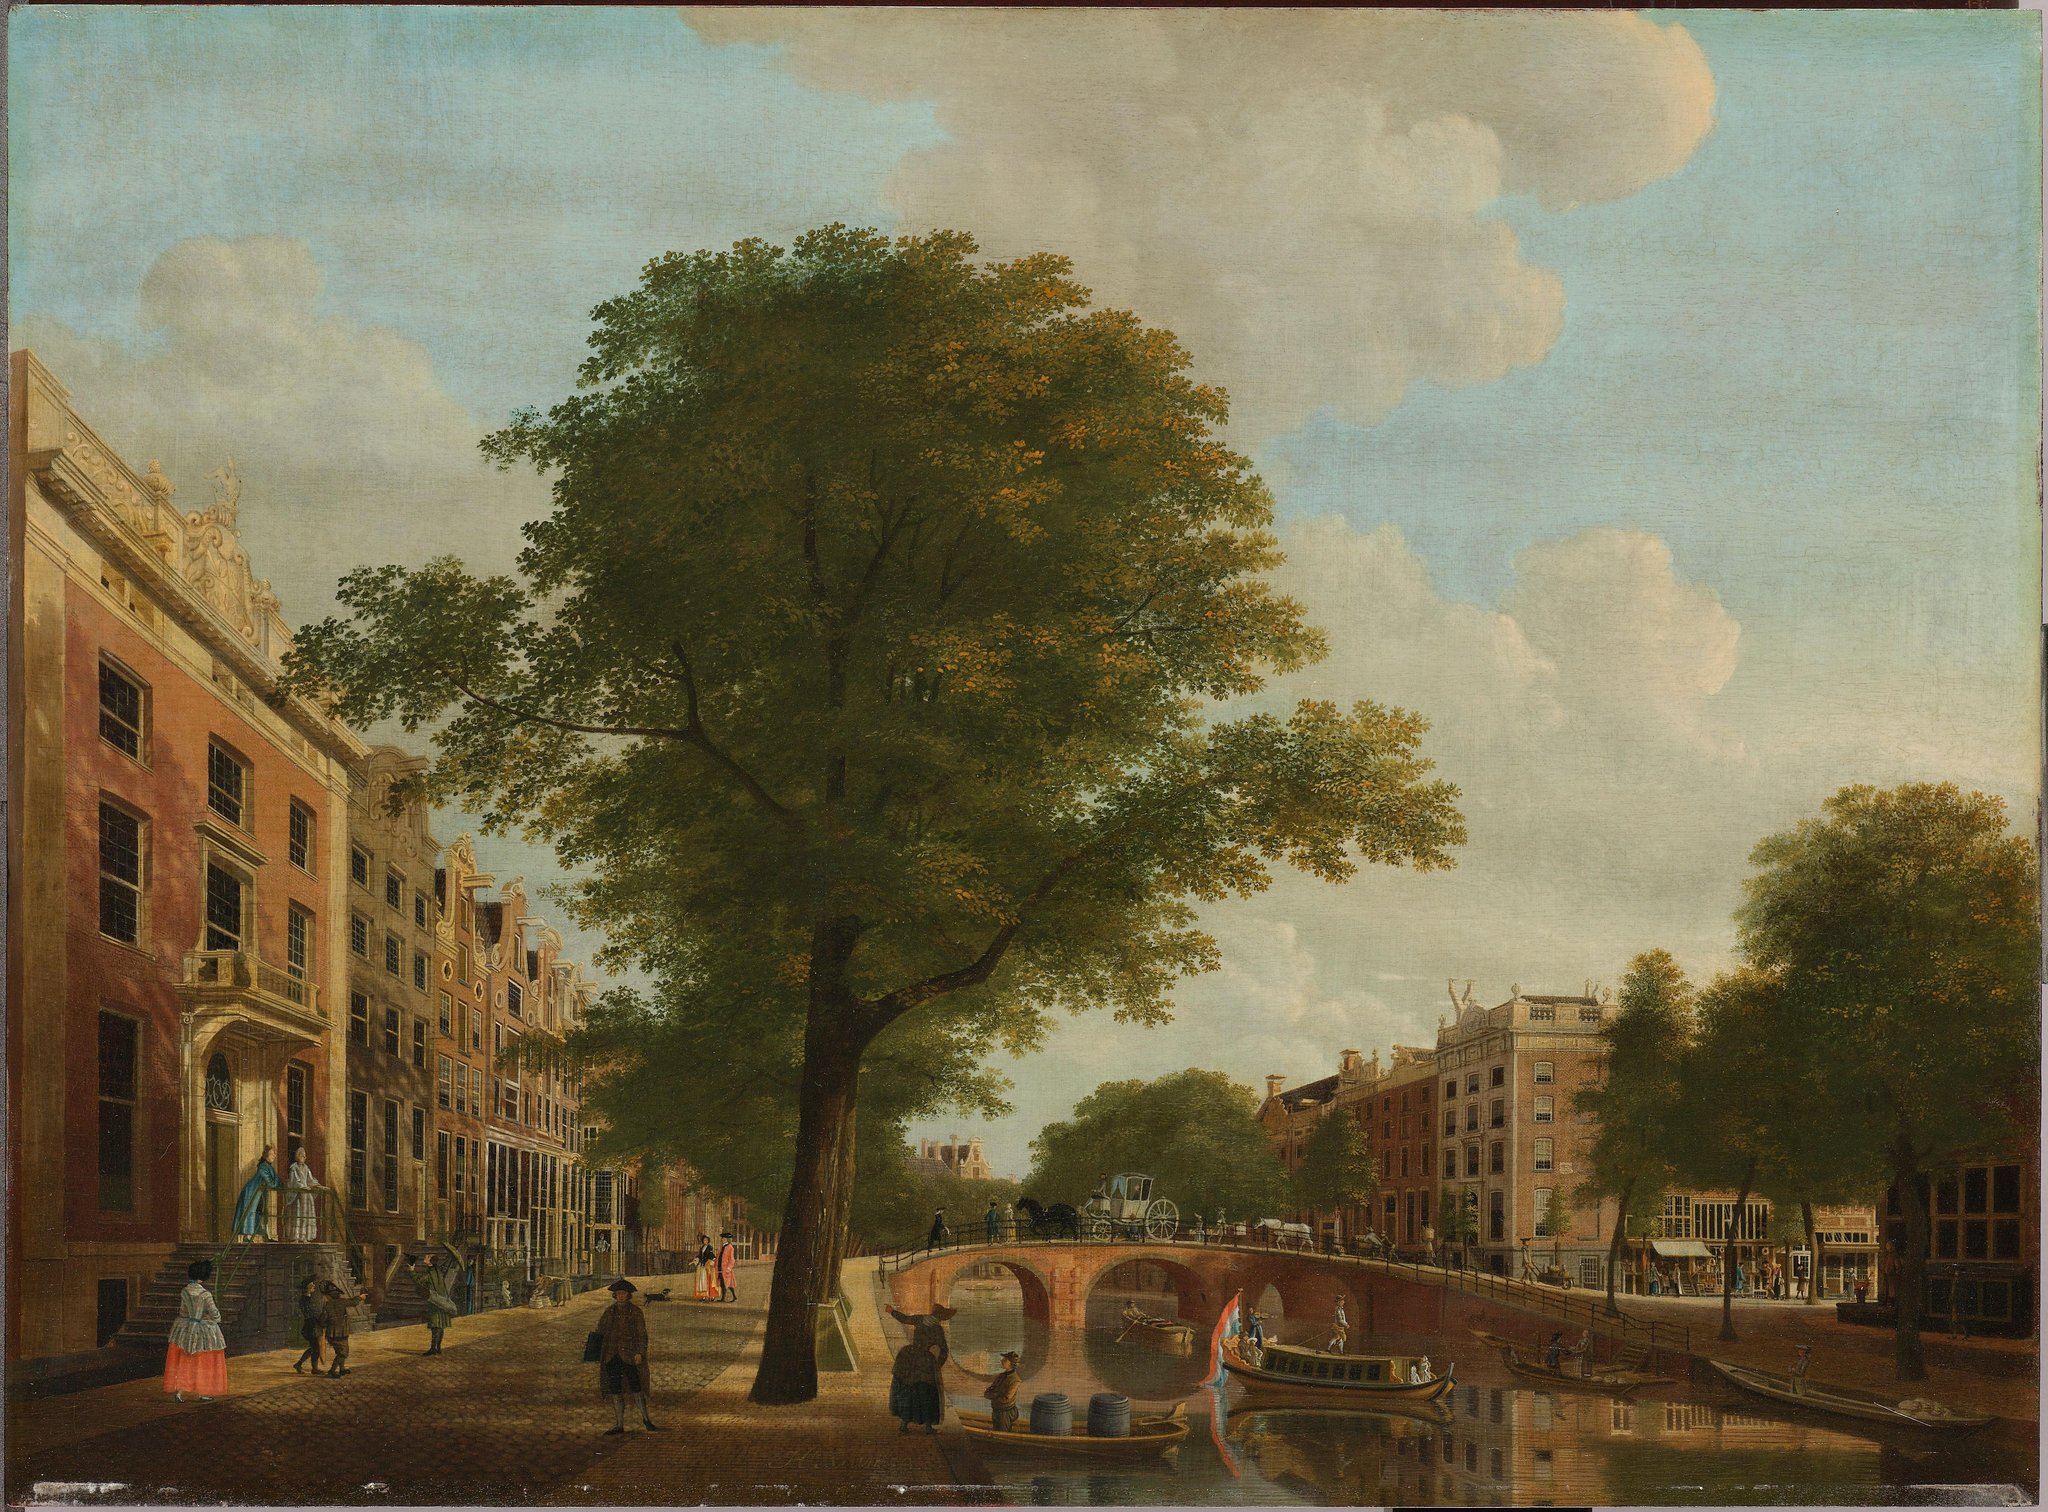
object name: painting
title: View of the Herengracht near the Leidsestraat, Amsterdam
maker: hendrik keun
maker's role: painter, print maker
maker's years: 1738-1787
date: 1774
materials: oil, panel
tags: canals, waters (in city) (+ city(-scape) with figures, staffage), street (+ city(-scape) with figures, staffage)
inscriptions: signature and date: ‘H Keun 1774’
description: Gezicht op de Herengracht bij de Leidsestraat te Amsterdam. Op de gracht varen verschillende kleine boten. Op de brug een rijtuig. Links het huis met nr. 436, waar een echtpaar, waarschijnlijk Cornelis G.J. van Wijckerslooth en Geertruida Maria Roest van Alkemade-Blesen, op de trap staat. Beneden probeert een parapluverkoper zijn waar te slijten.